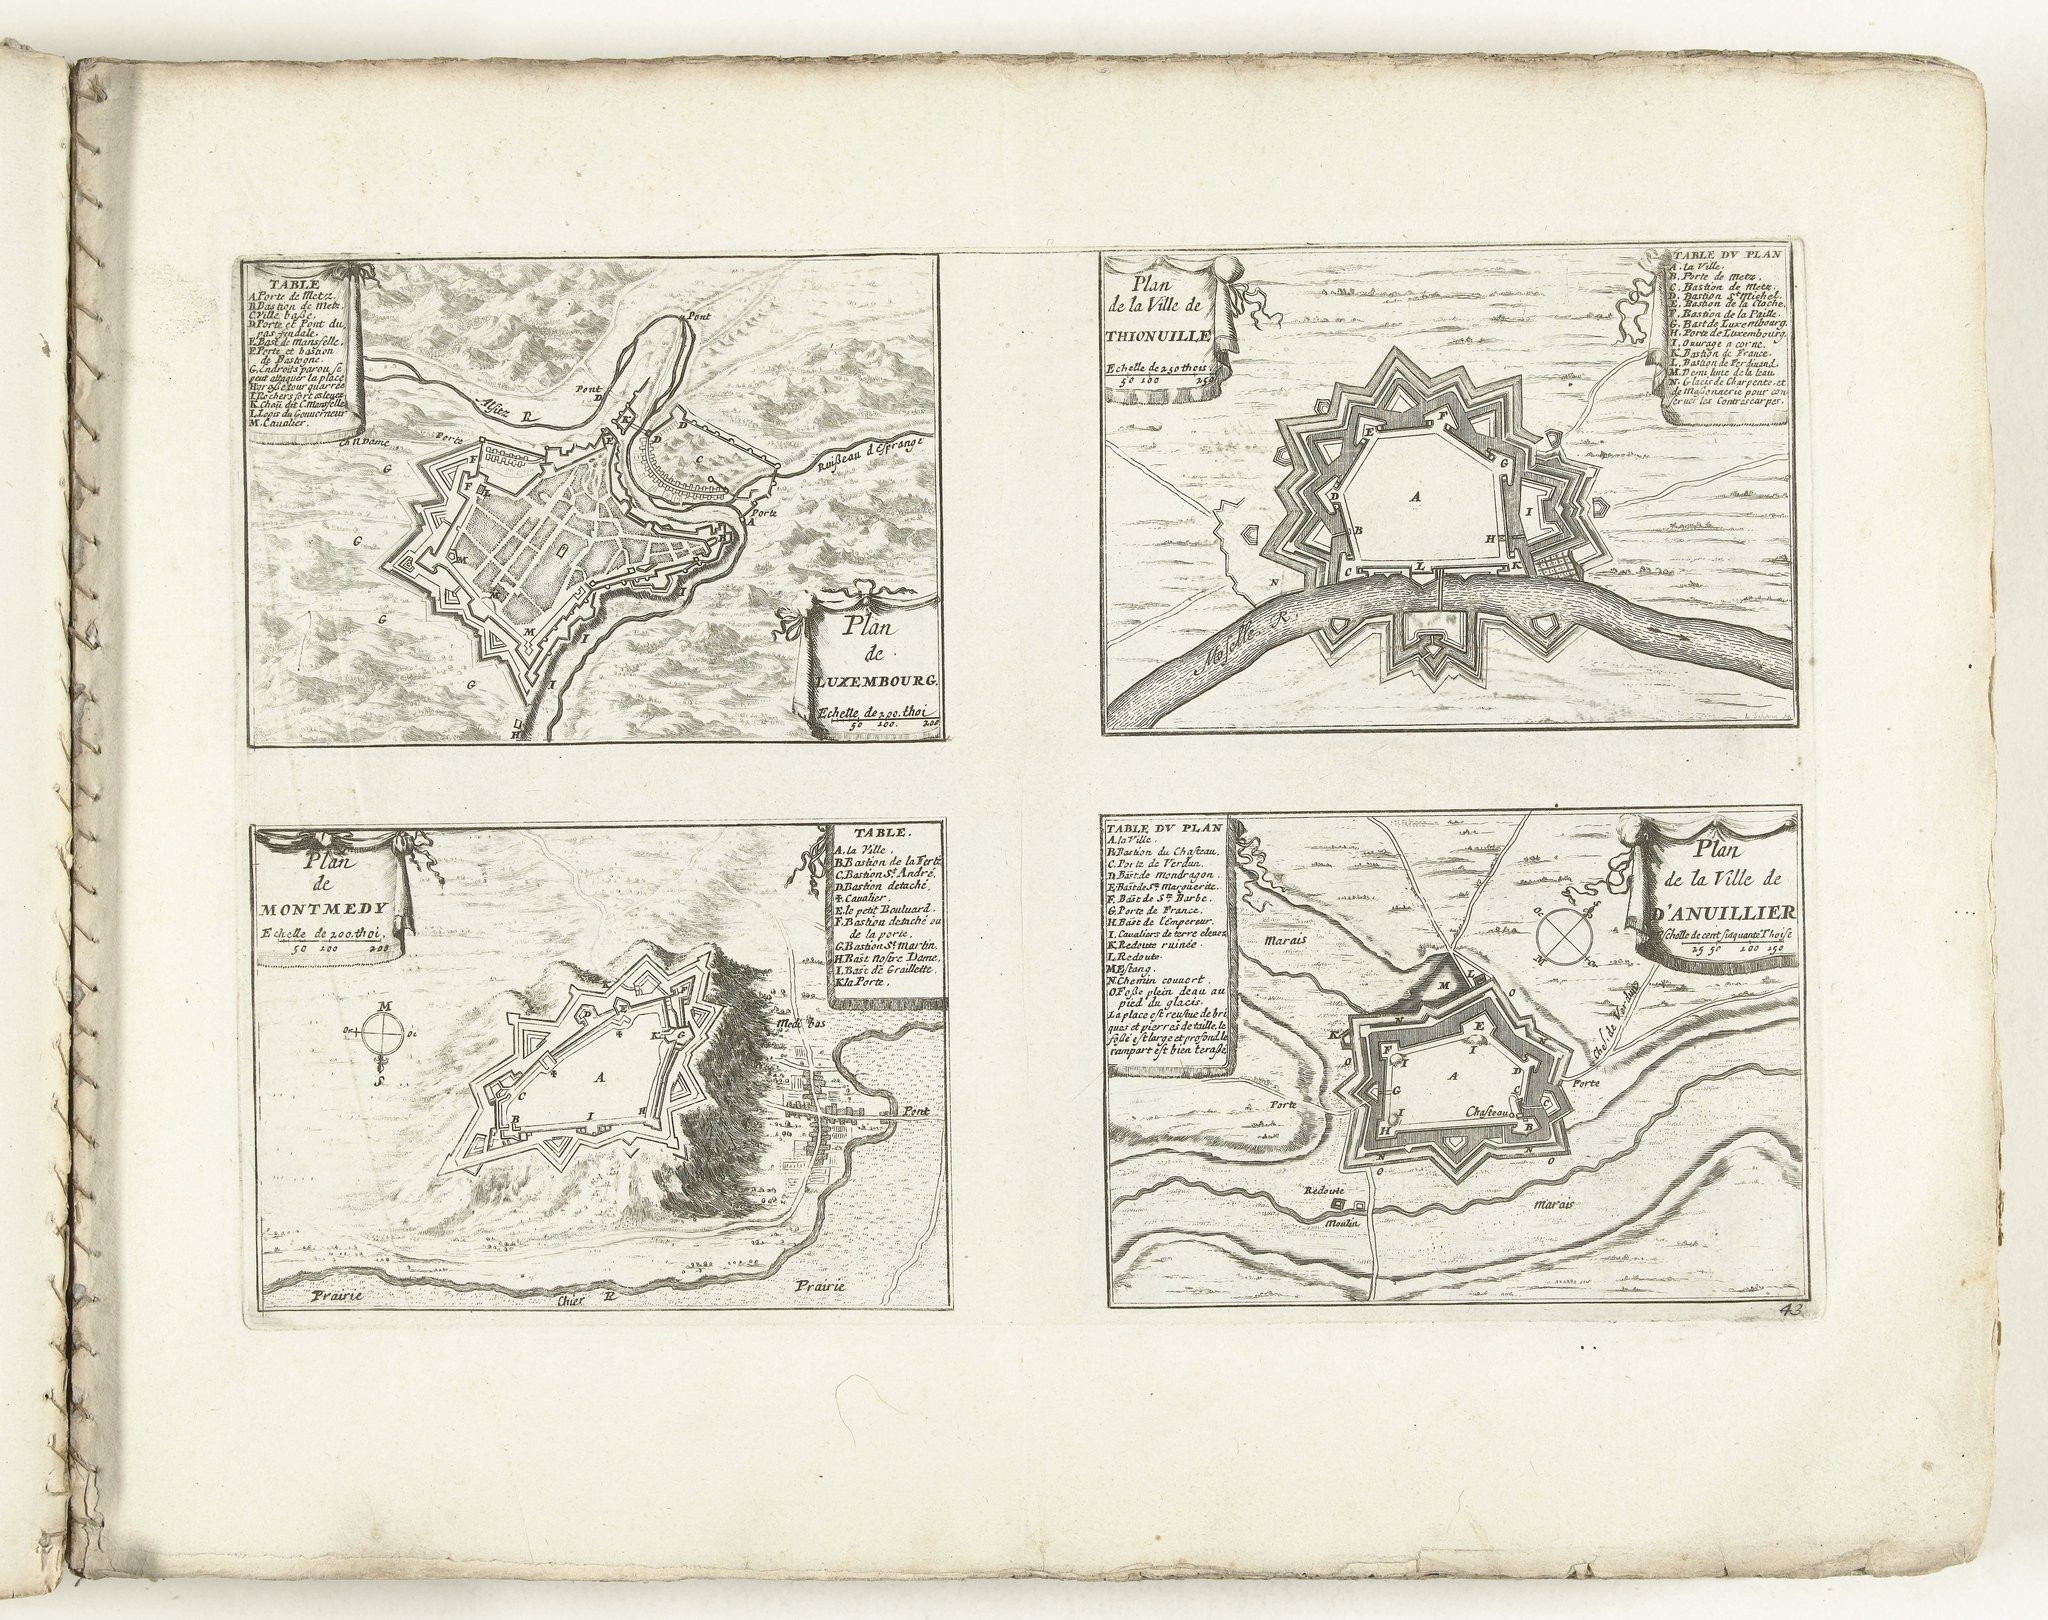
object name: print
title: Luxembourg / Thionville / Montmedy / D'Anvillier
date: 1702-1703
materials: paper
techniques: etching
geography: amsterdam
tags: fortress, maps of cities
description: Blad met vier plattegronden van de verdedigingswerken om de steden Luxemburg, Thionville, Montmédy en Damvillers. Plaat nr. 43 in het prentwerk bestaande in totaal uit 276 genummerde platen van vermaarde sterke steden en vestingen in het kader van de Spaanse Successieoorlog. Voor het merendeel zijn deze platen gekopieerd naar de anonieme Franse platen: in Les forces de l'Europe en in: Le theatre de la guerre, dans les Pays-Bas, beide oorspronkelijk uitgegeven door Nicolas de Fer te Parijs (1693-1697) in het kader van de Negenjarige Oorlog. Titels en opschriften in de plaat in het Frans.